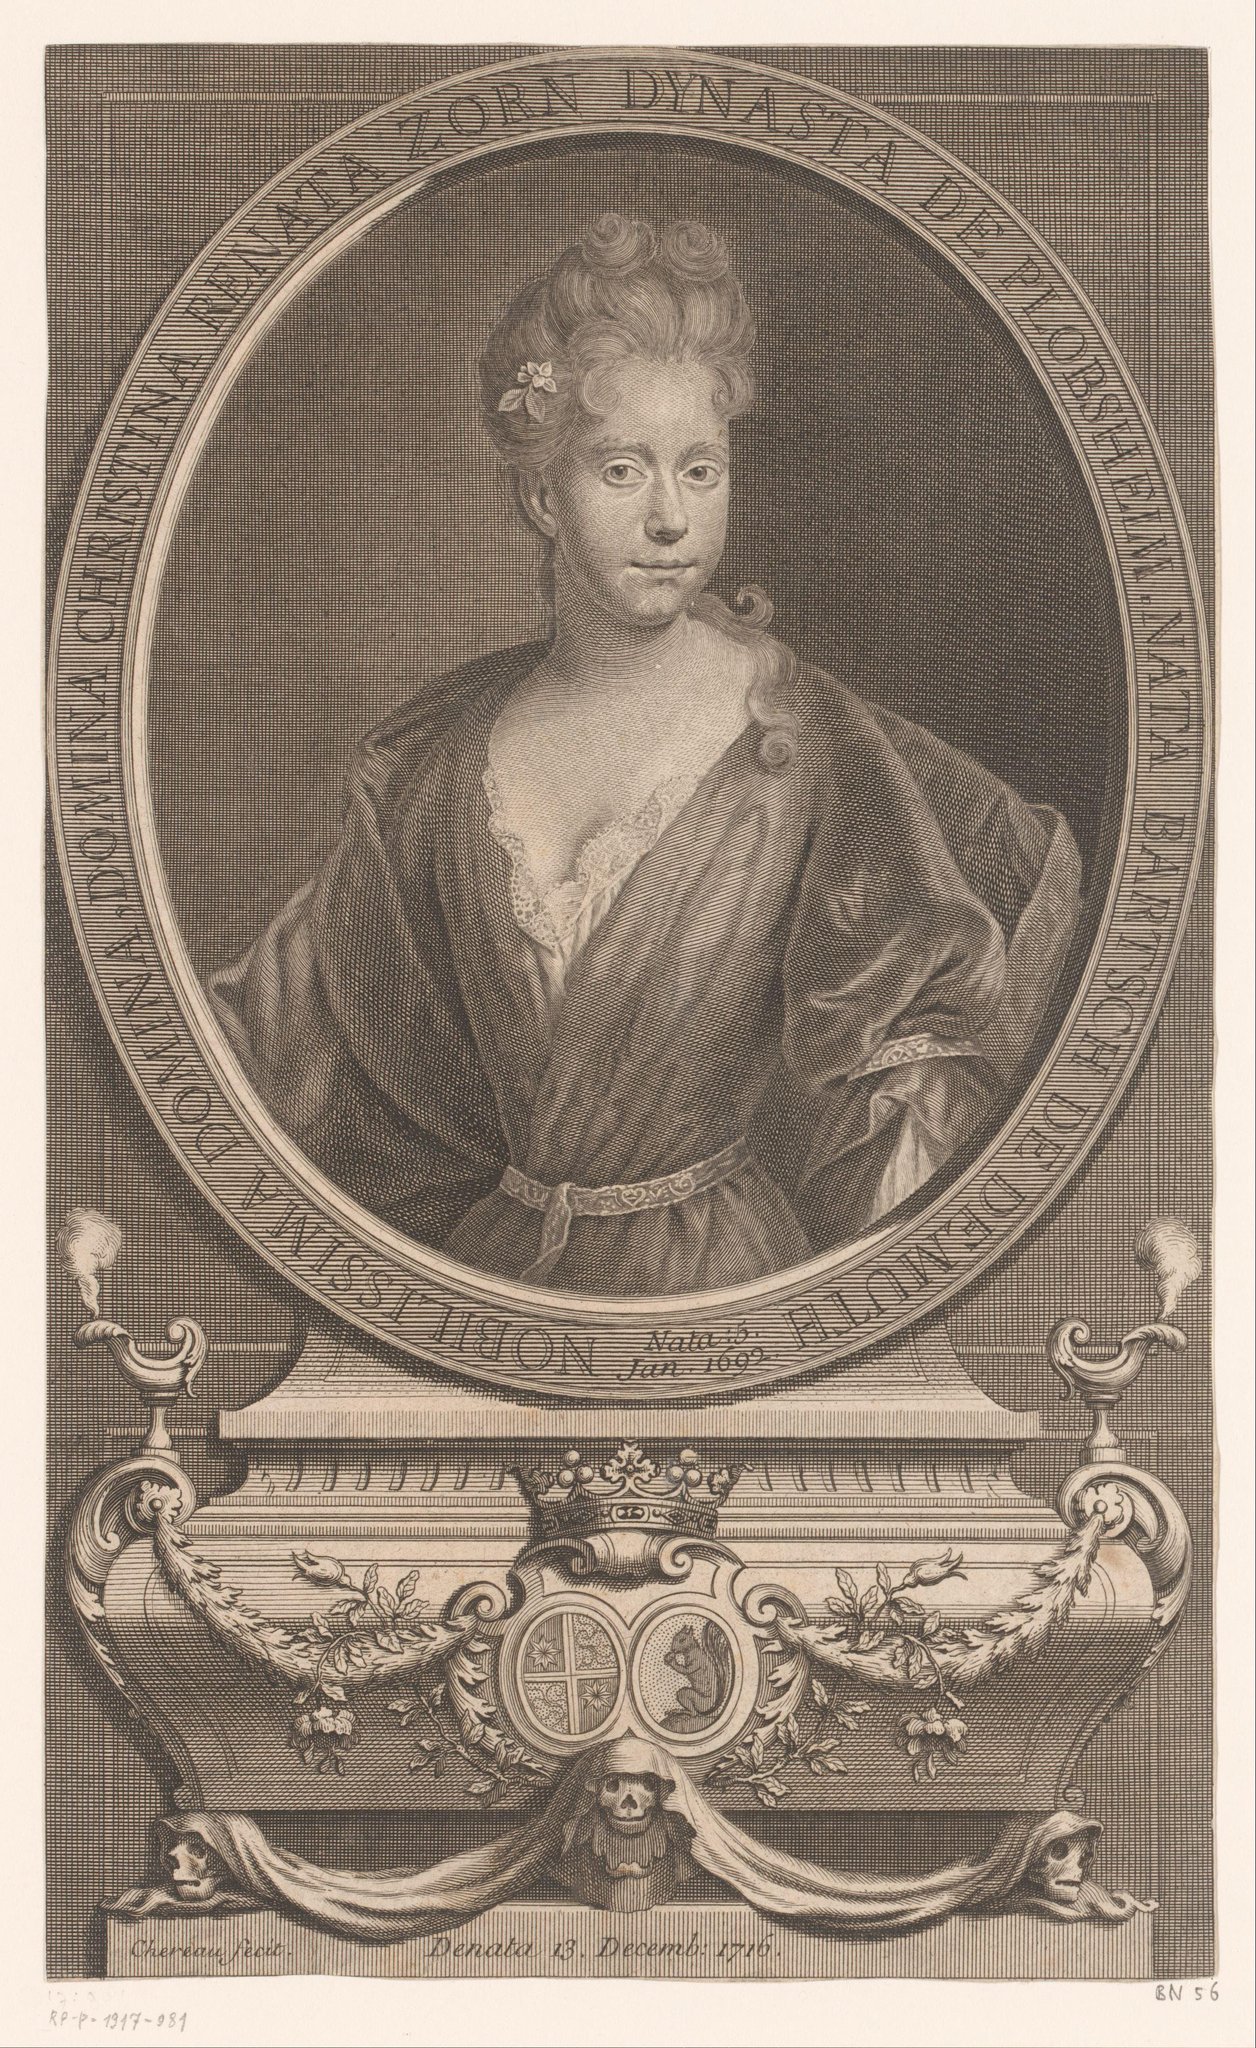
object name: print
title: Noblissima domina, domina Christina Renata Zorn dynasta de Plobsheim, nata Bartsch de Demuth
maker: françois chéreau (i)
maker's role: print maker, publisher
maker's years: 1680-1729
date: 1716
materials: paper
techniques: engraving, etching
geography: france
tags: ornament ~ medallion, historical persons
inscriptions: collector's mark: Lugt 2228